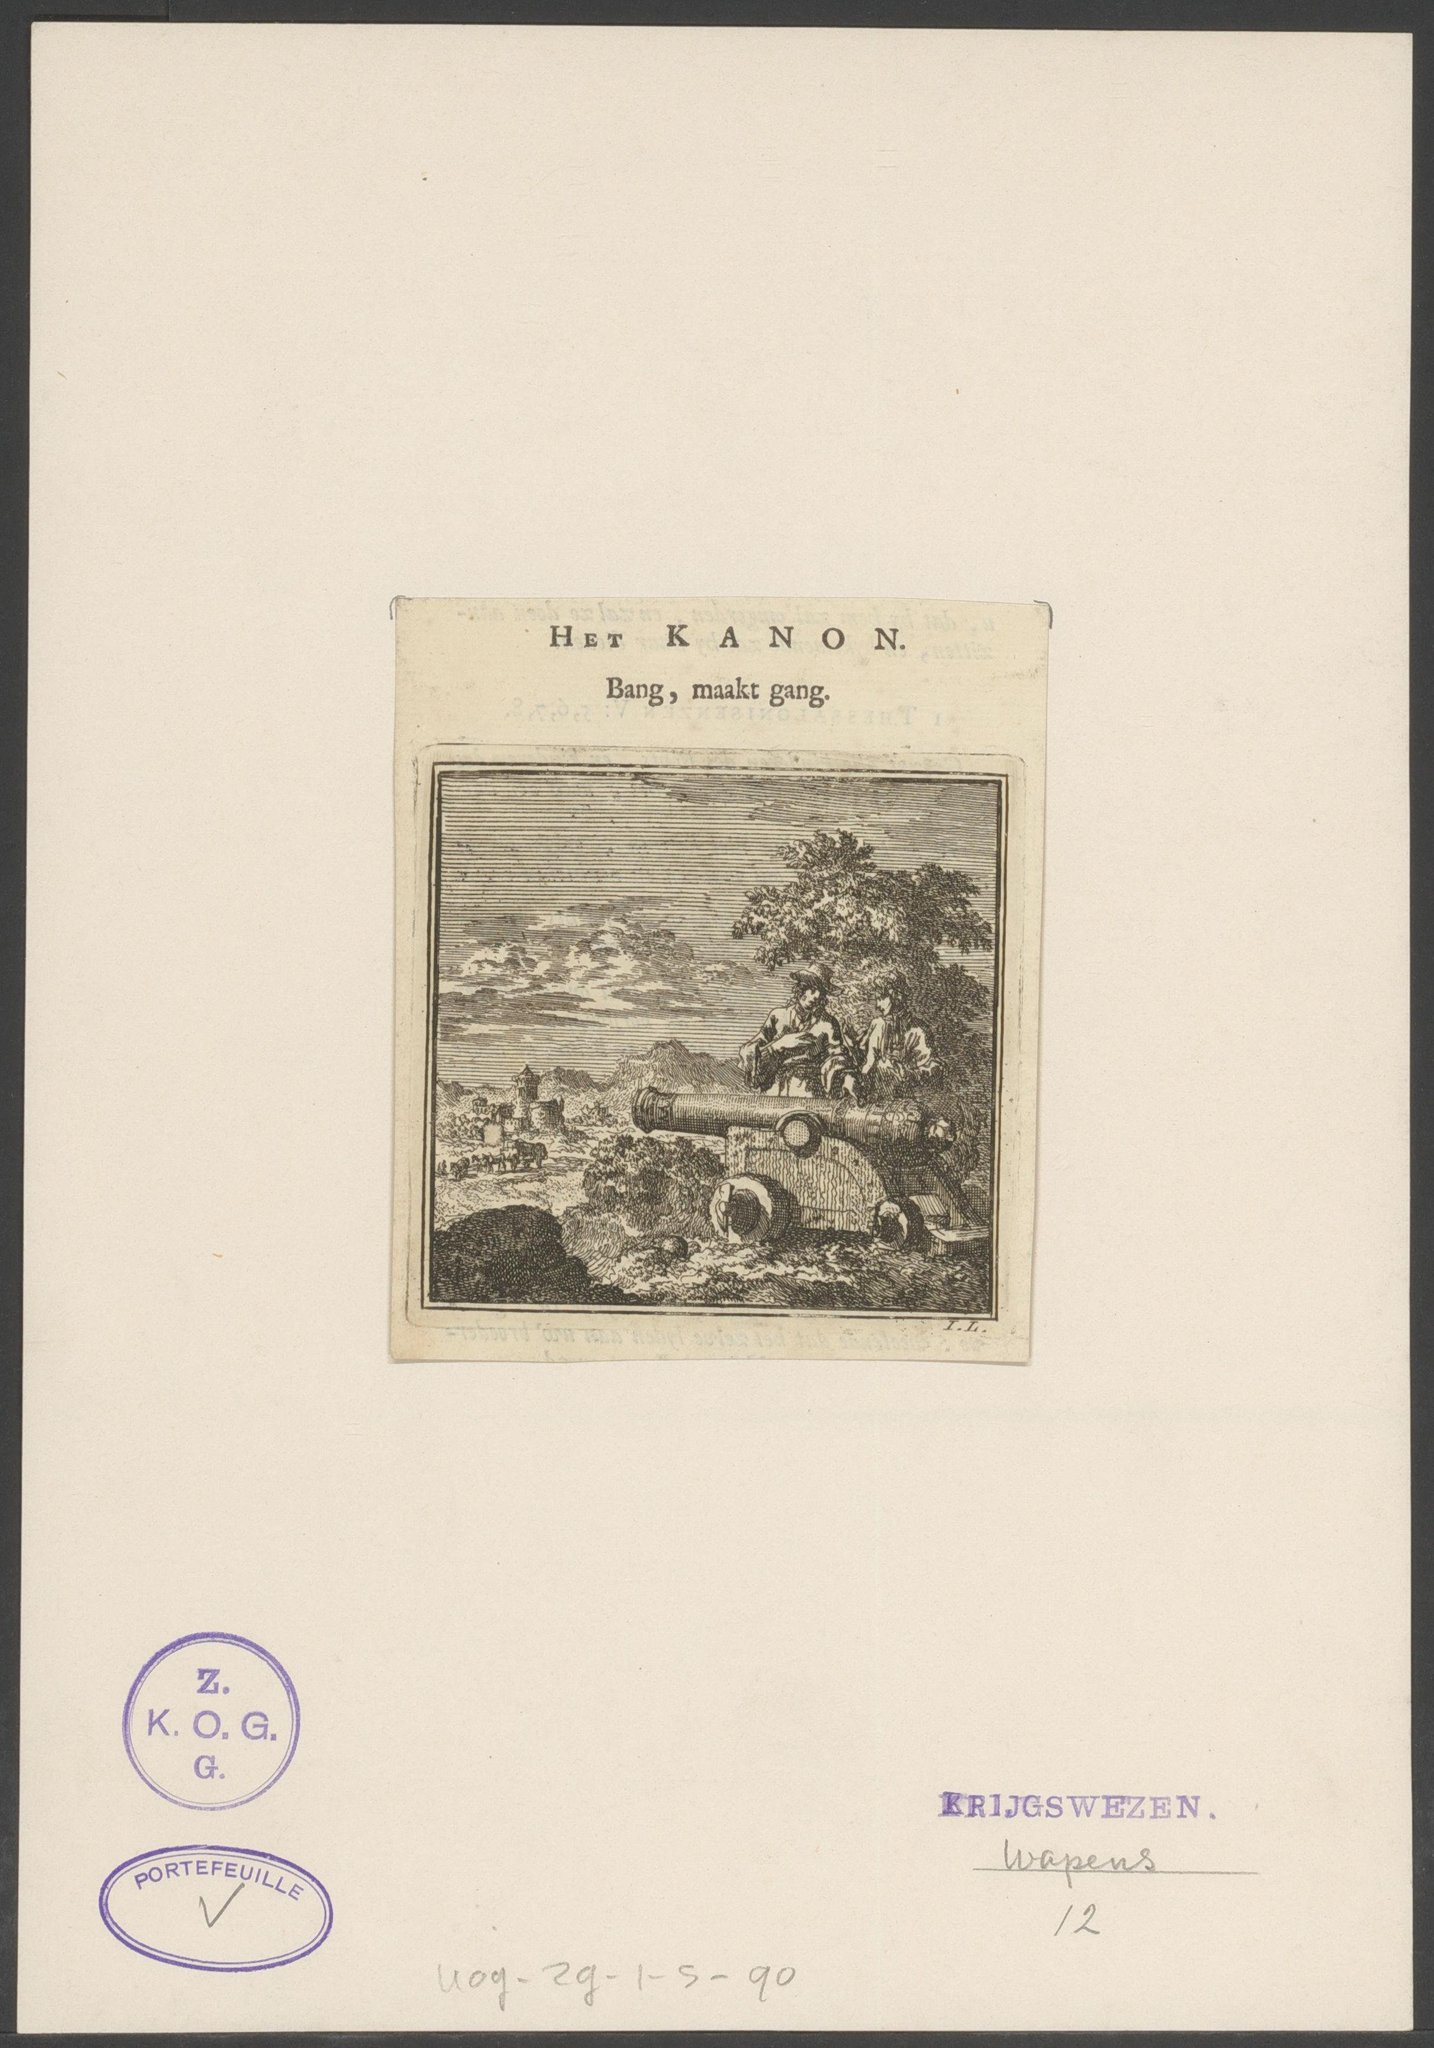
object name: book illustration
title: Kanon in een berglandschap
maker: jan luyken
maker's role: draughtsman, print maker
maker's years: 1649-1712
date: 1711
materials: paper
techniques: etching, letterpress printing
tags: firearms: cannon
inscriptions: stamp, collector's mark: Lugt 1641, stamp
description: Prent met tekst op verso gebruikt in: Luyken, Jan. De Bykorf des Gemoeds. Amsterdam: Pieter Arentsz. II (wed.) en Cornelis van der Sys, 1711.